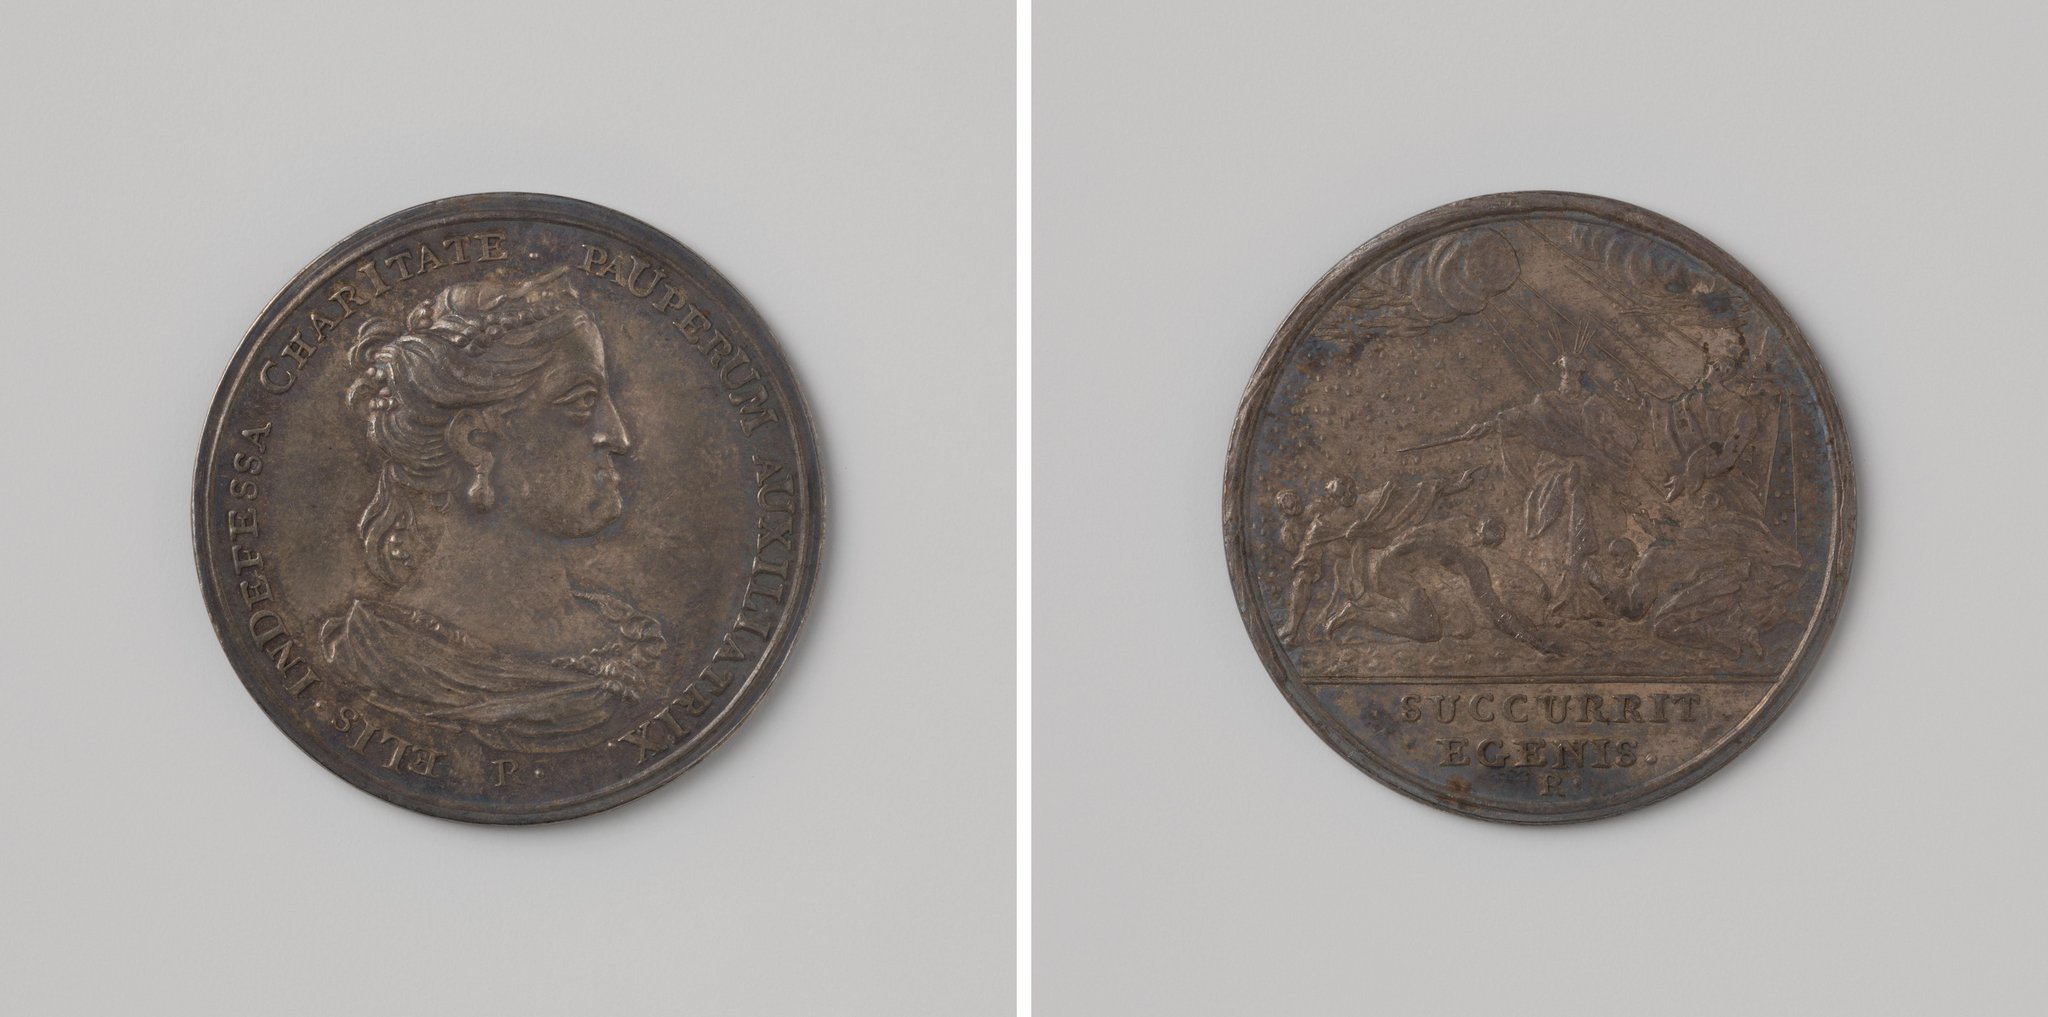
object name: new year medal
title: Weldadigheid van Maria Elisabeth, landvoogdes der zuidelijke Nederlanden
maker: jacques roëttiers (ii)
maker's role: medailleur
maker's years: 1698-1772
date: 1741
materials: silver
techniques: striking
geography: antwerp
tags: landvoogd, maria elisabeth (aartshertogin van oostenrijk)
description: Zilveren penning. Voorzijde: borststuk vrouw met diadeem binnen omschrift. Keerzijde: knielende mensen rapen manna, die uit hemel valt van de grond, temidden van hen staat Mozes voor een tent; afsnede: opschrift